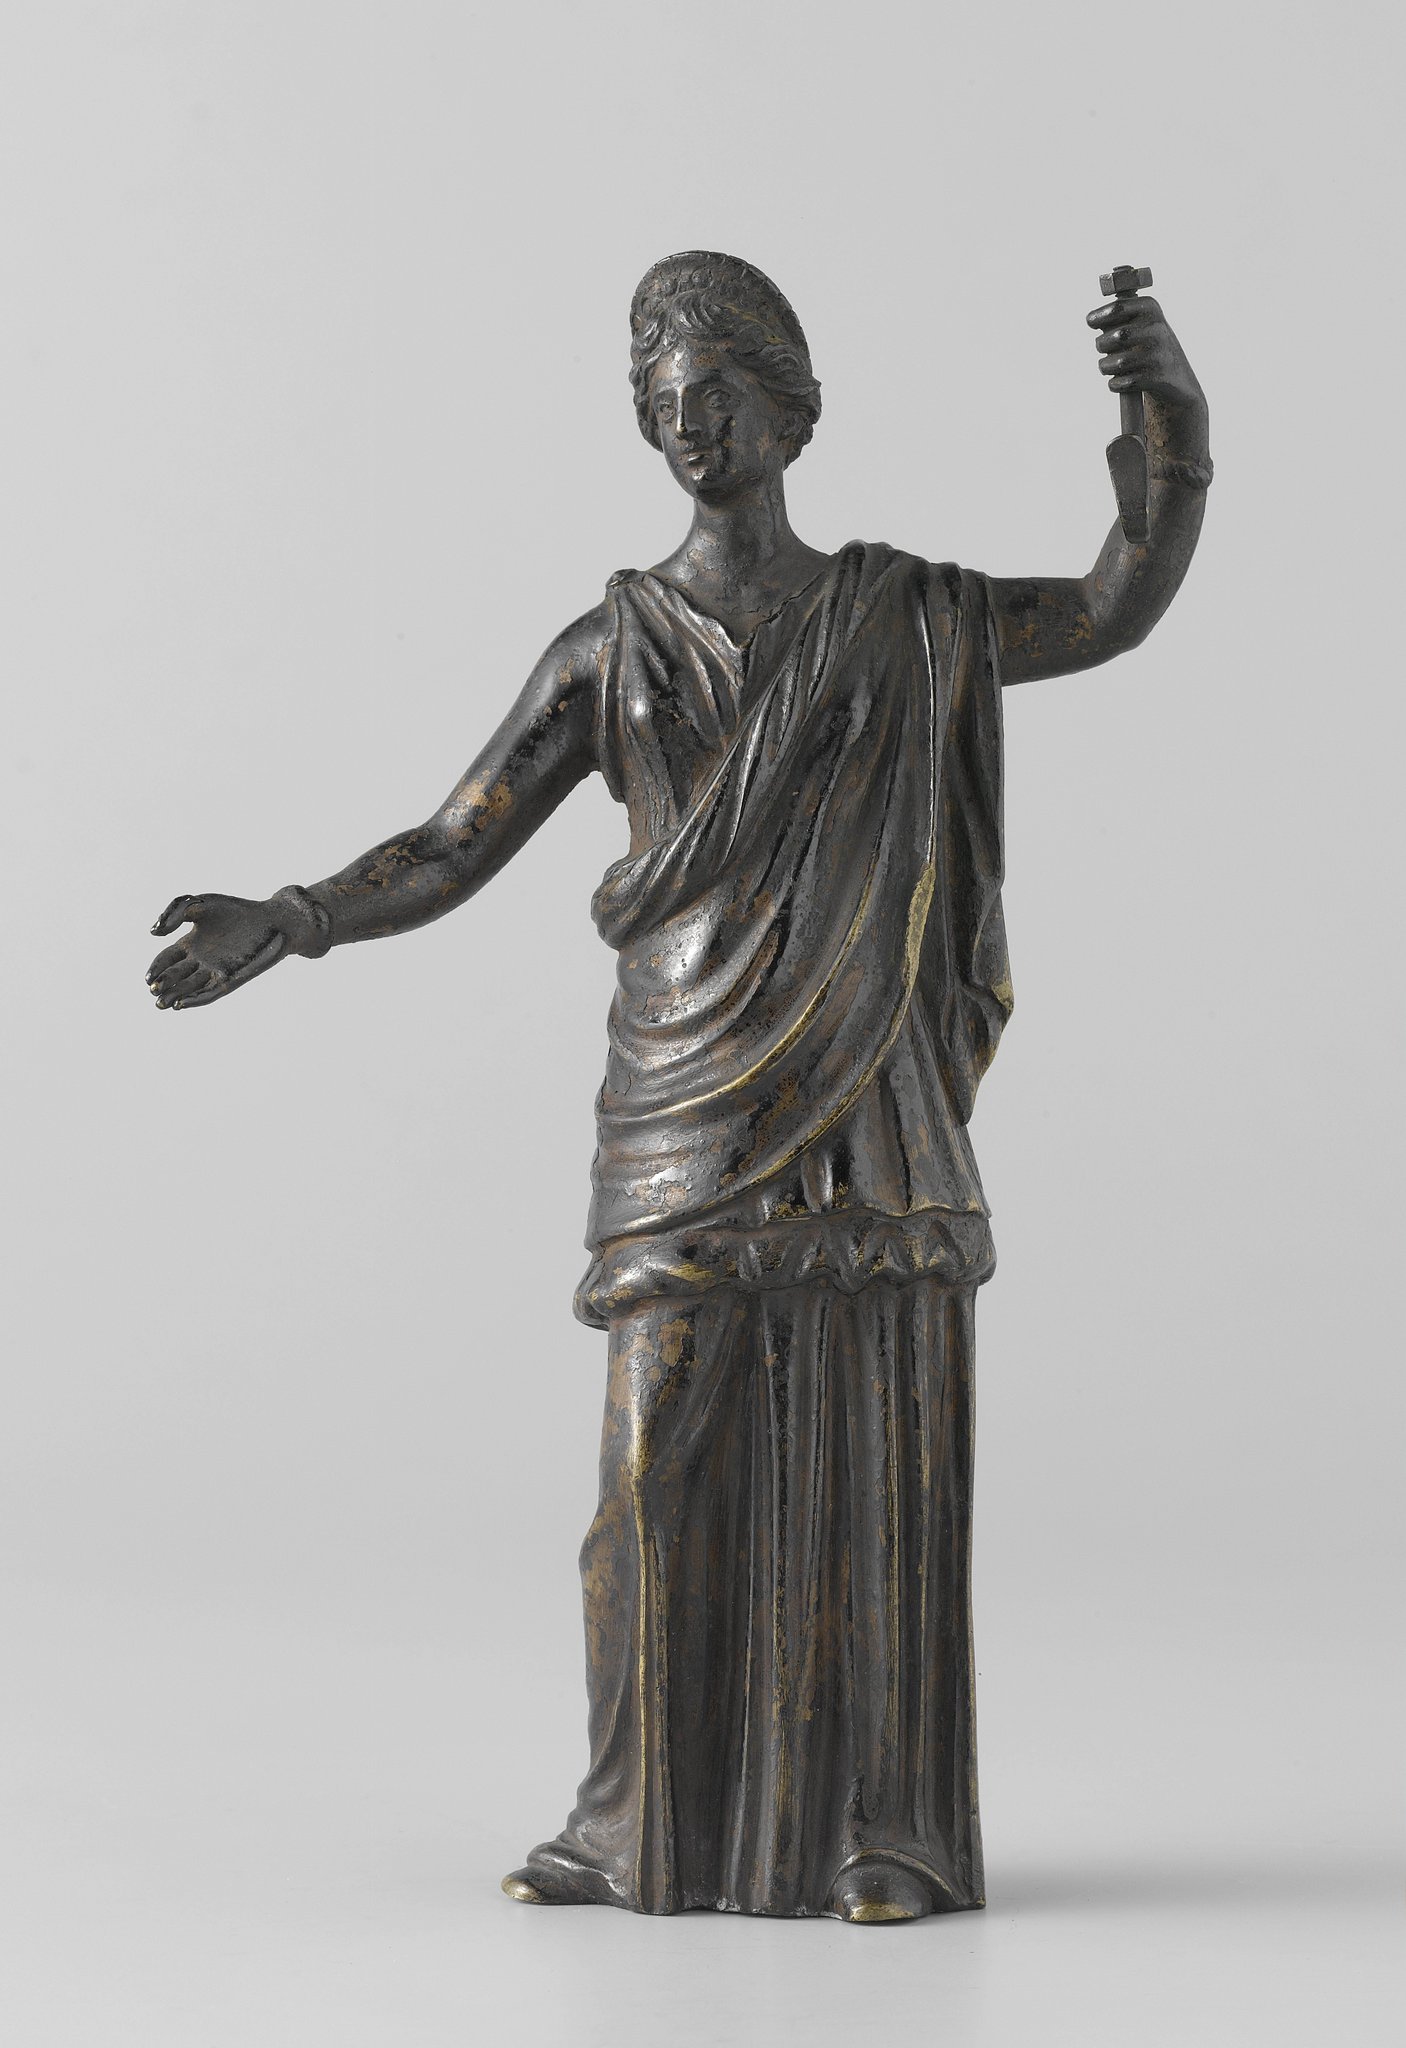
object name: sculpture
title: Staande vrouw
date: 1500-1600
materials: bronze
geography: italy